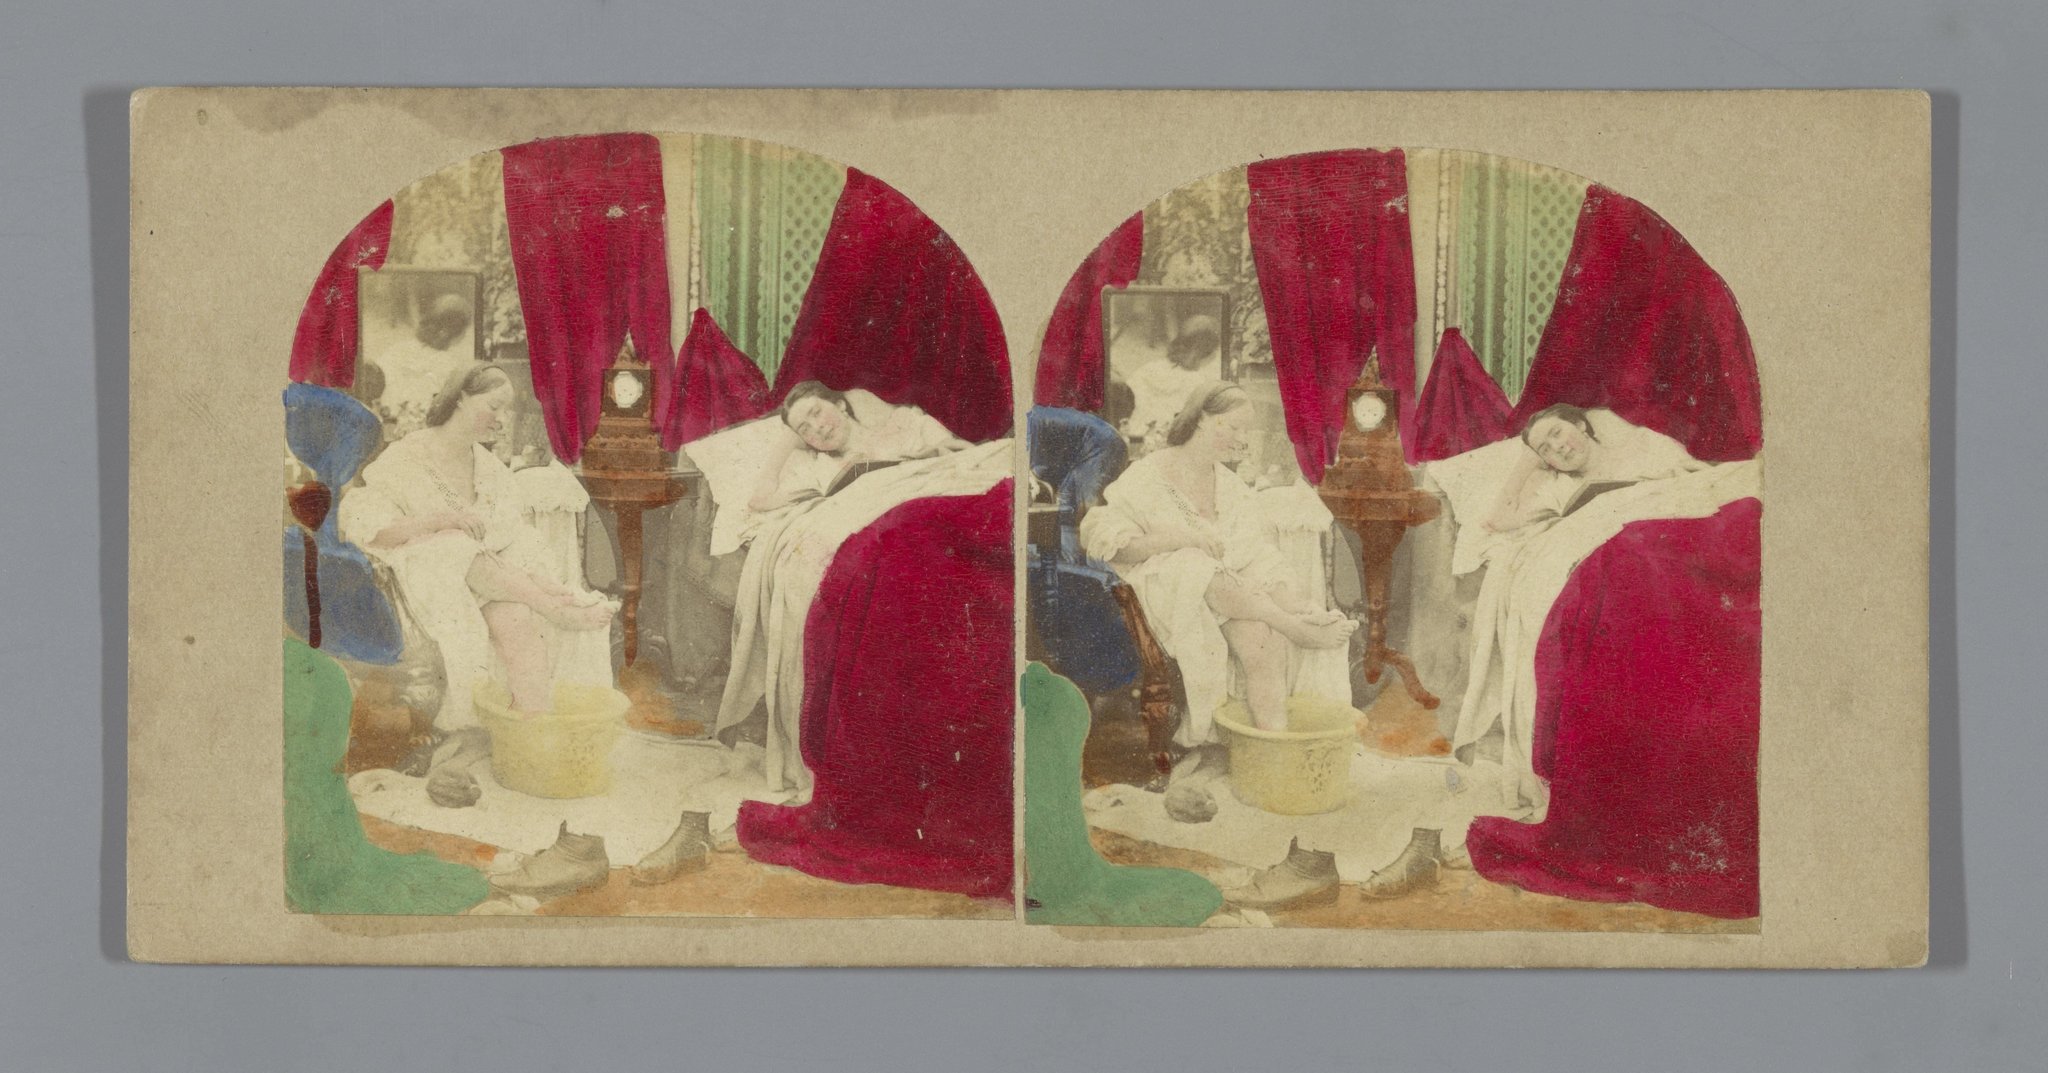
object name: stereograph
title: The Foot Bath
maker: Anonymous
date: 1852-1858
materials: cardboard, paper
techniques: albumen print, hand coloring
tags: adult woman